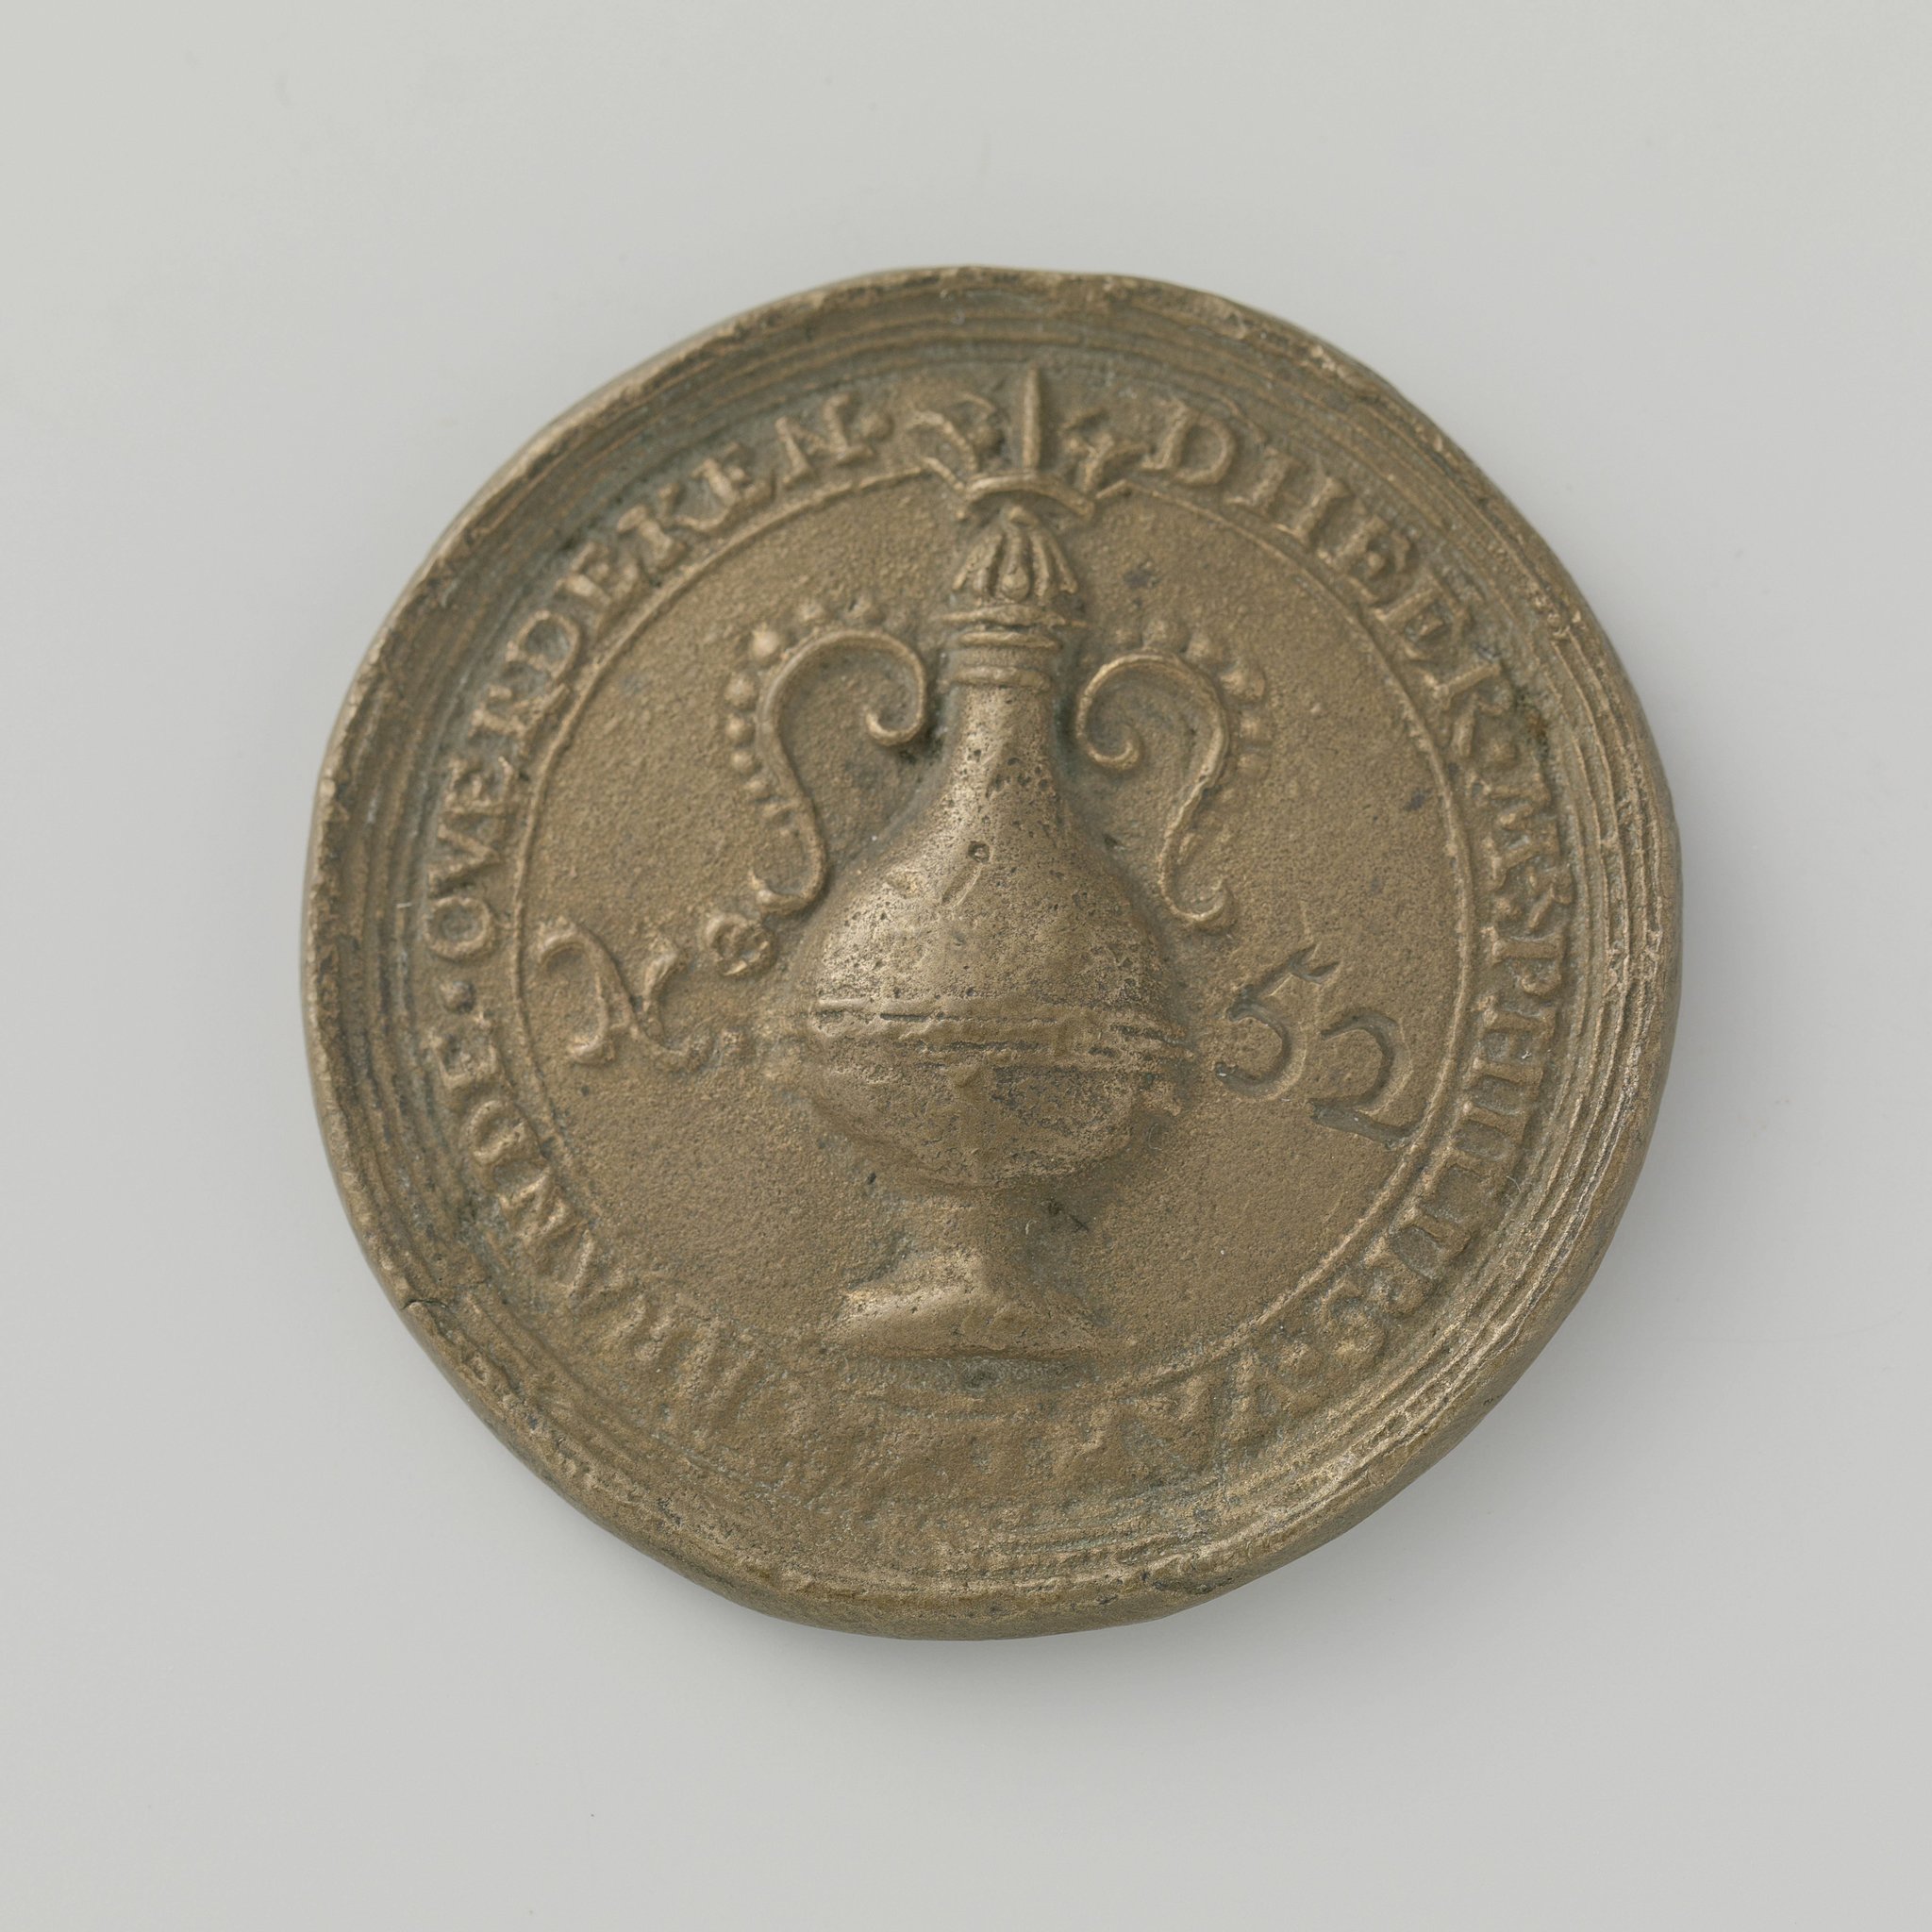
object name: medal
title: Cloth Shearers, Zierikzee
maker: Anonymous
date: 1630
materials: brass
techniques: casting, engraving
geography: zierikzee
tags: philips van den brande, zierikzee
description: Guild medals Members of trade guilds had to identify themselves with a medal at their meetings.